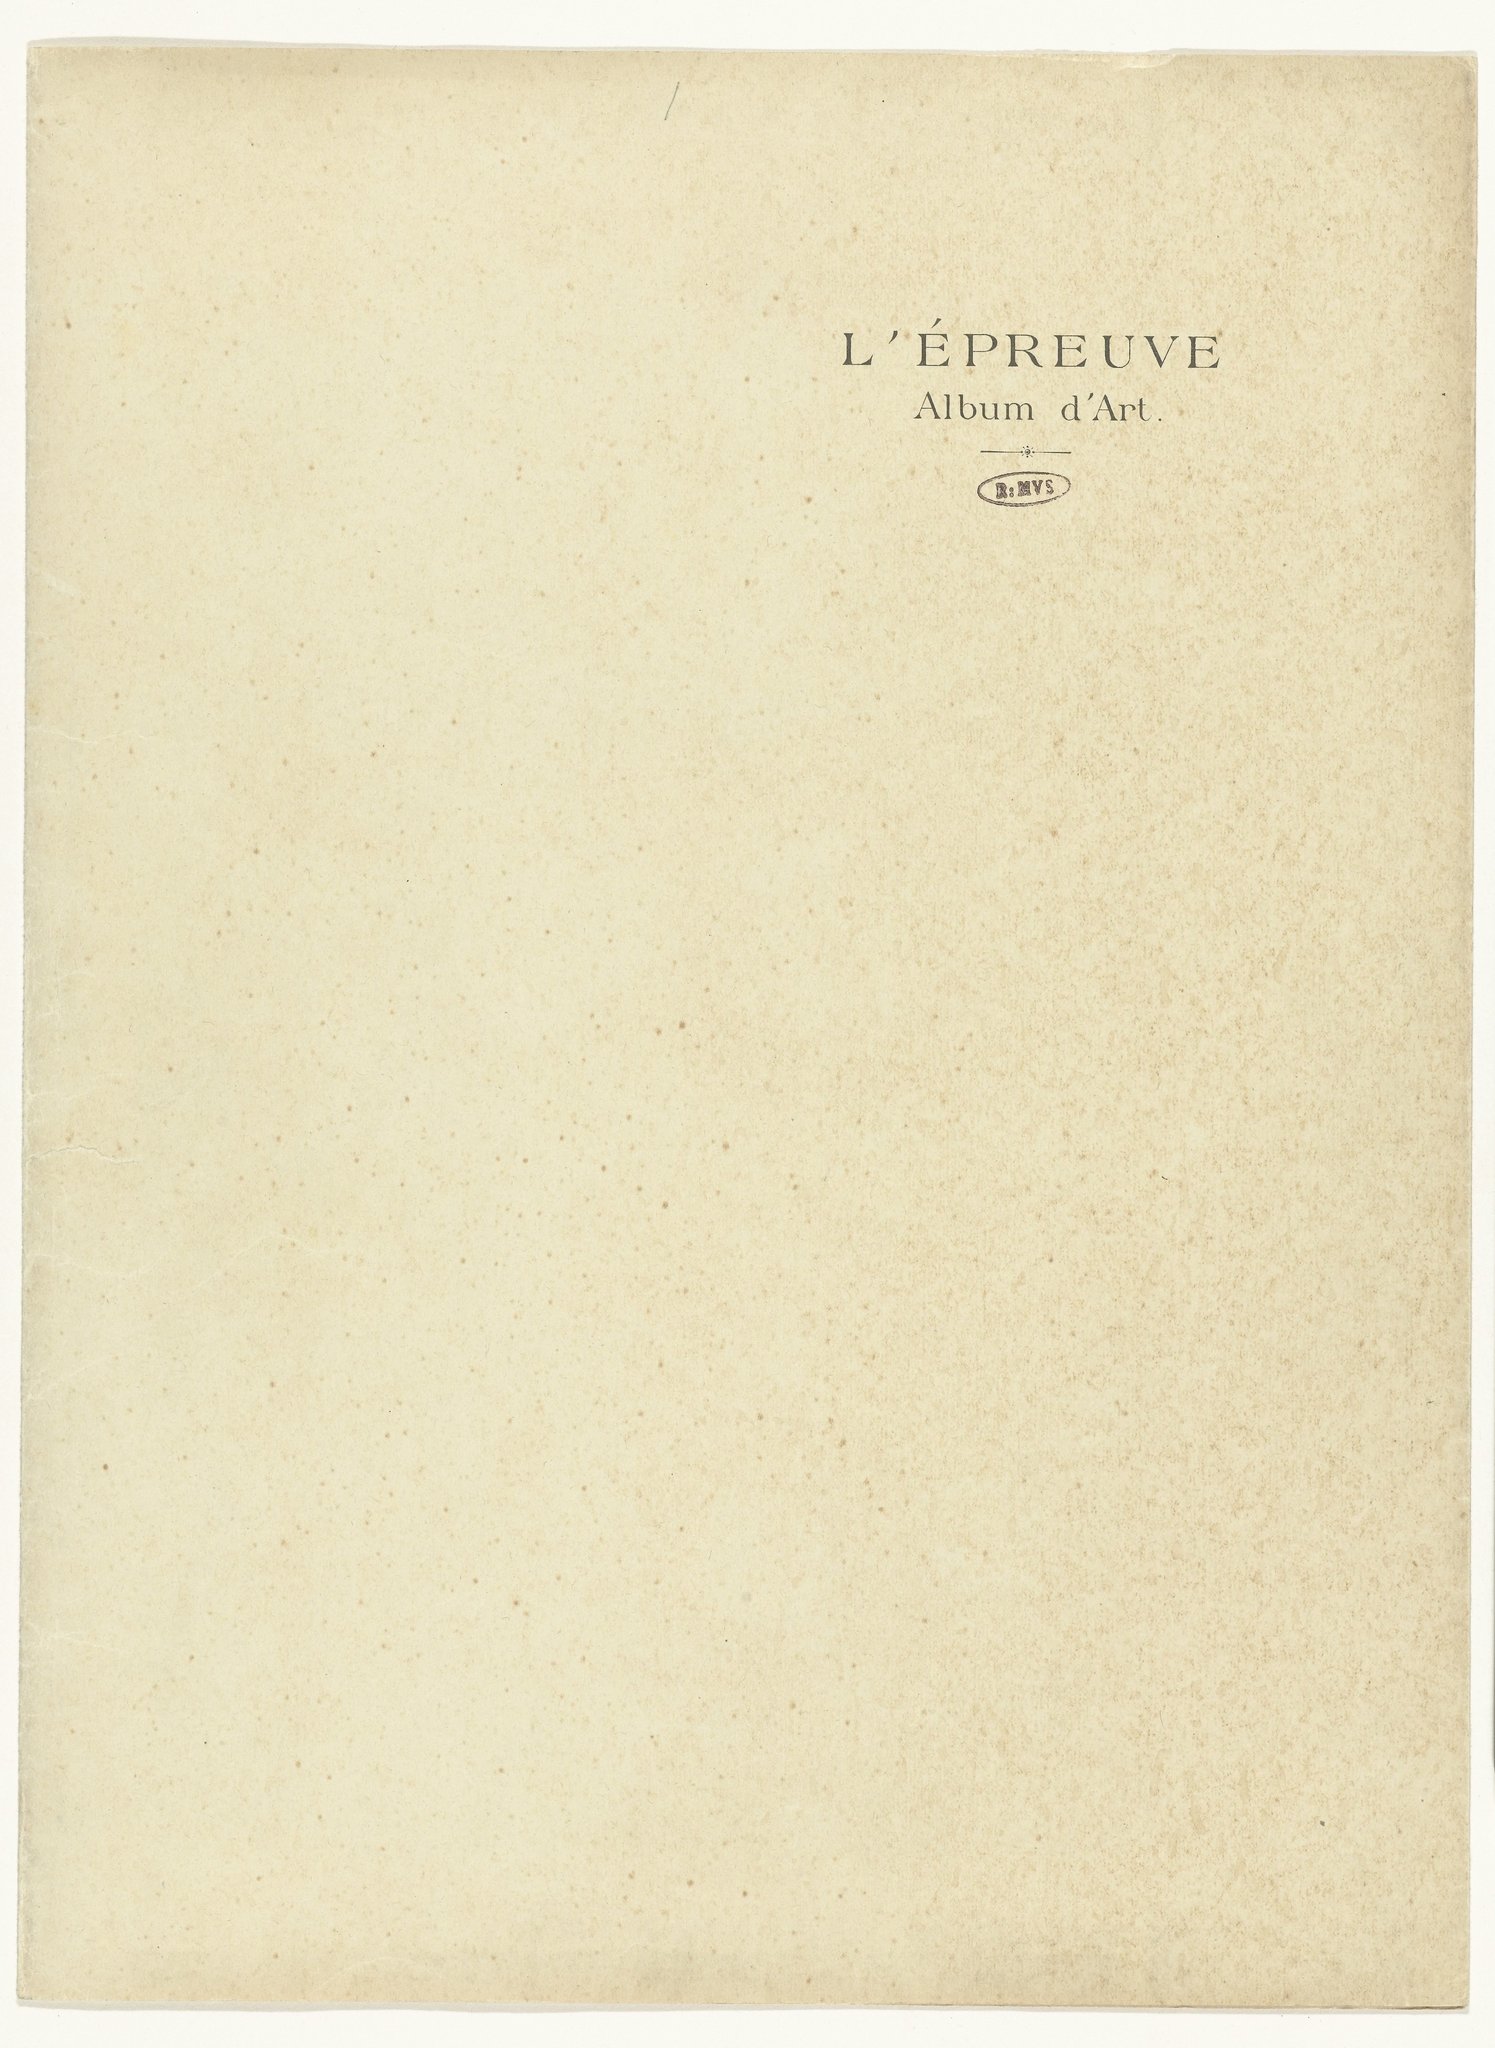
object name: print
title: Omslag Album d'Art als supplement bij tijdschrift L'Epreuve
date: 1895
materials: paper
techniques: lithograph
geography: paris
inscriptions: collector's mark: Lugt 2760, collector's mark: Lugt 2228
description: Het tijdschrift L'Epreuve verscheen maandelijks van december 1894- december 1895 en besteedde aandacht aan kunst en literatuur. Deze omslag met titel L'Epreuve Album d'Art bevatte tien originele prenten van bekende kunstenaars als losse bijlage of supplement.